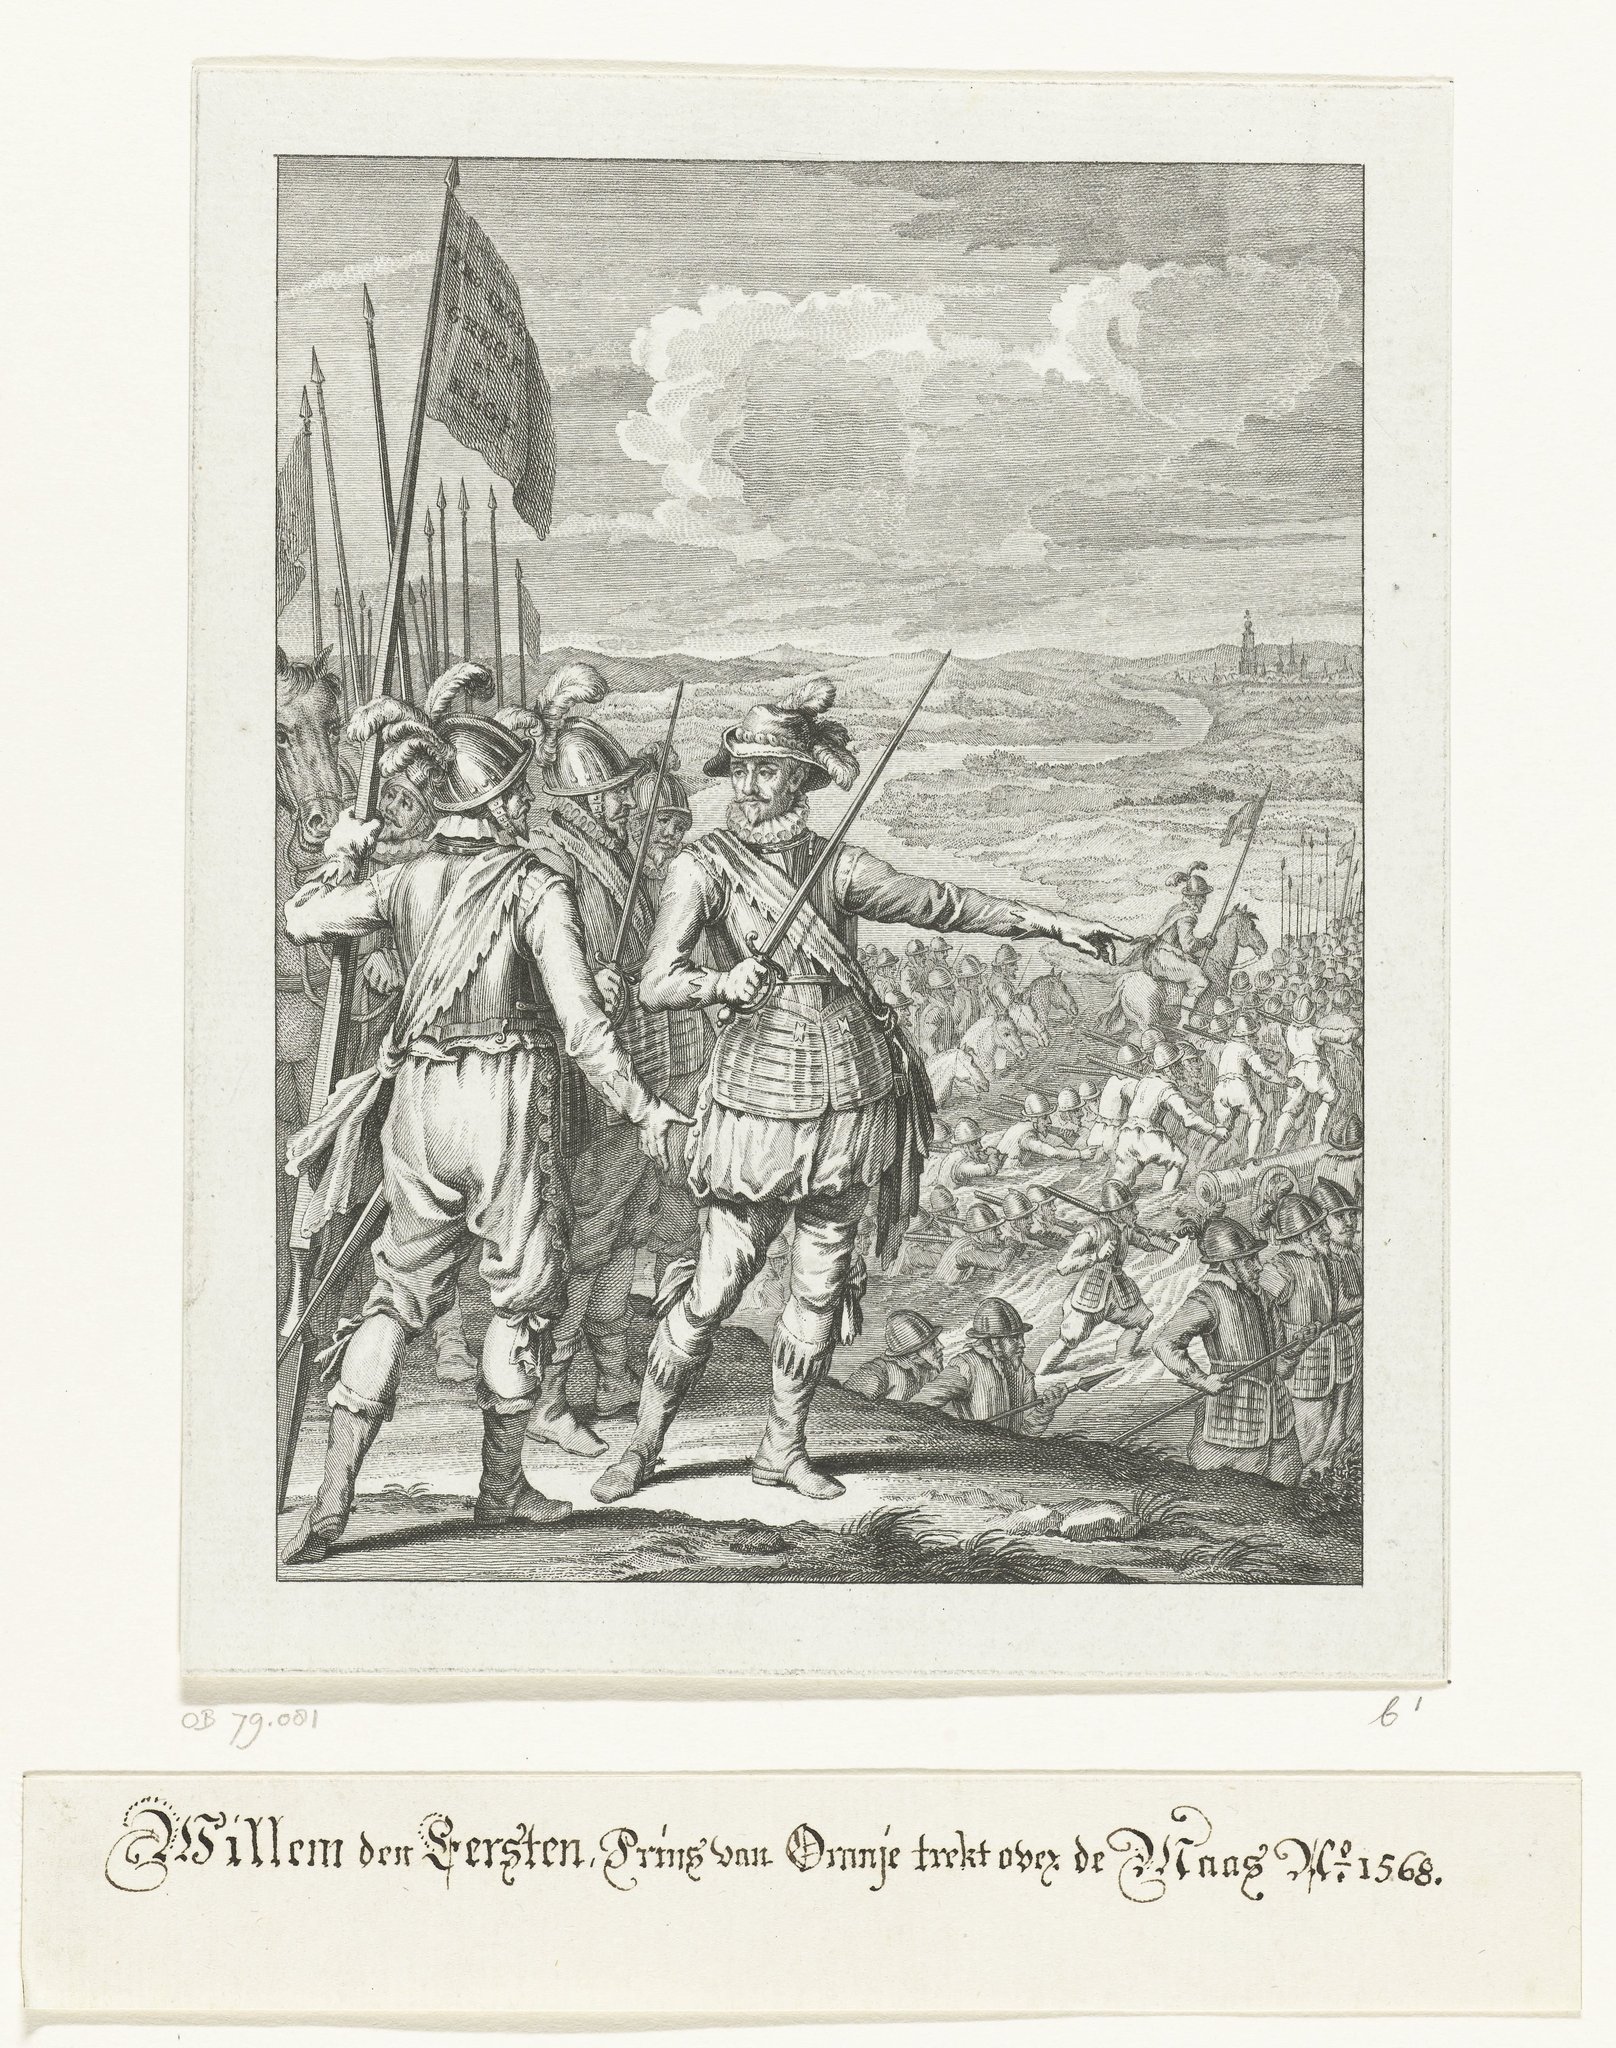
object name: history print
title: Taferelen uit het leven van prins Willem I, 1568-1584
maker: theodoor koning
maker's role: print maker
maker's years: 1748-1829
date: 1779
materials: paper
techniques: etching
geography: northern netherlands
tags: delft, william i (prince of orange), army 'en route' (+ land forces), maastricht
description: Illustratie voor: J. Nomsz, Willem de eerste, of de grondlegging der Nederlandsche vryheid. : In vier en twintig zangen, Erven van David Klippink, Amsterdam 1779. Staat vóór de letter. Met de handgeschreven titel in pen in bruin op een apart papiertje.